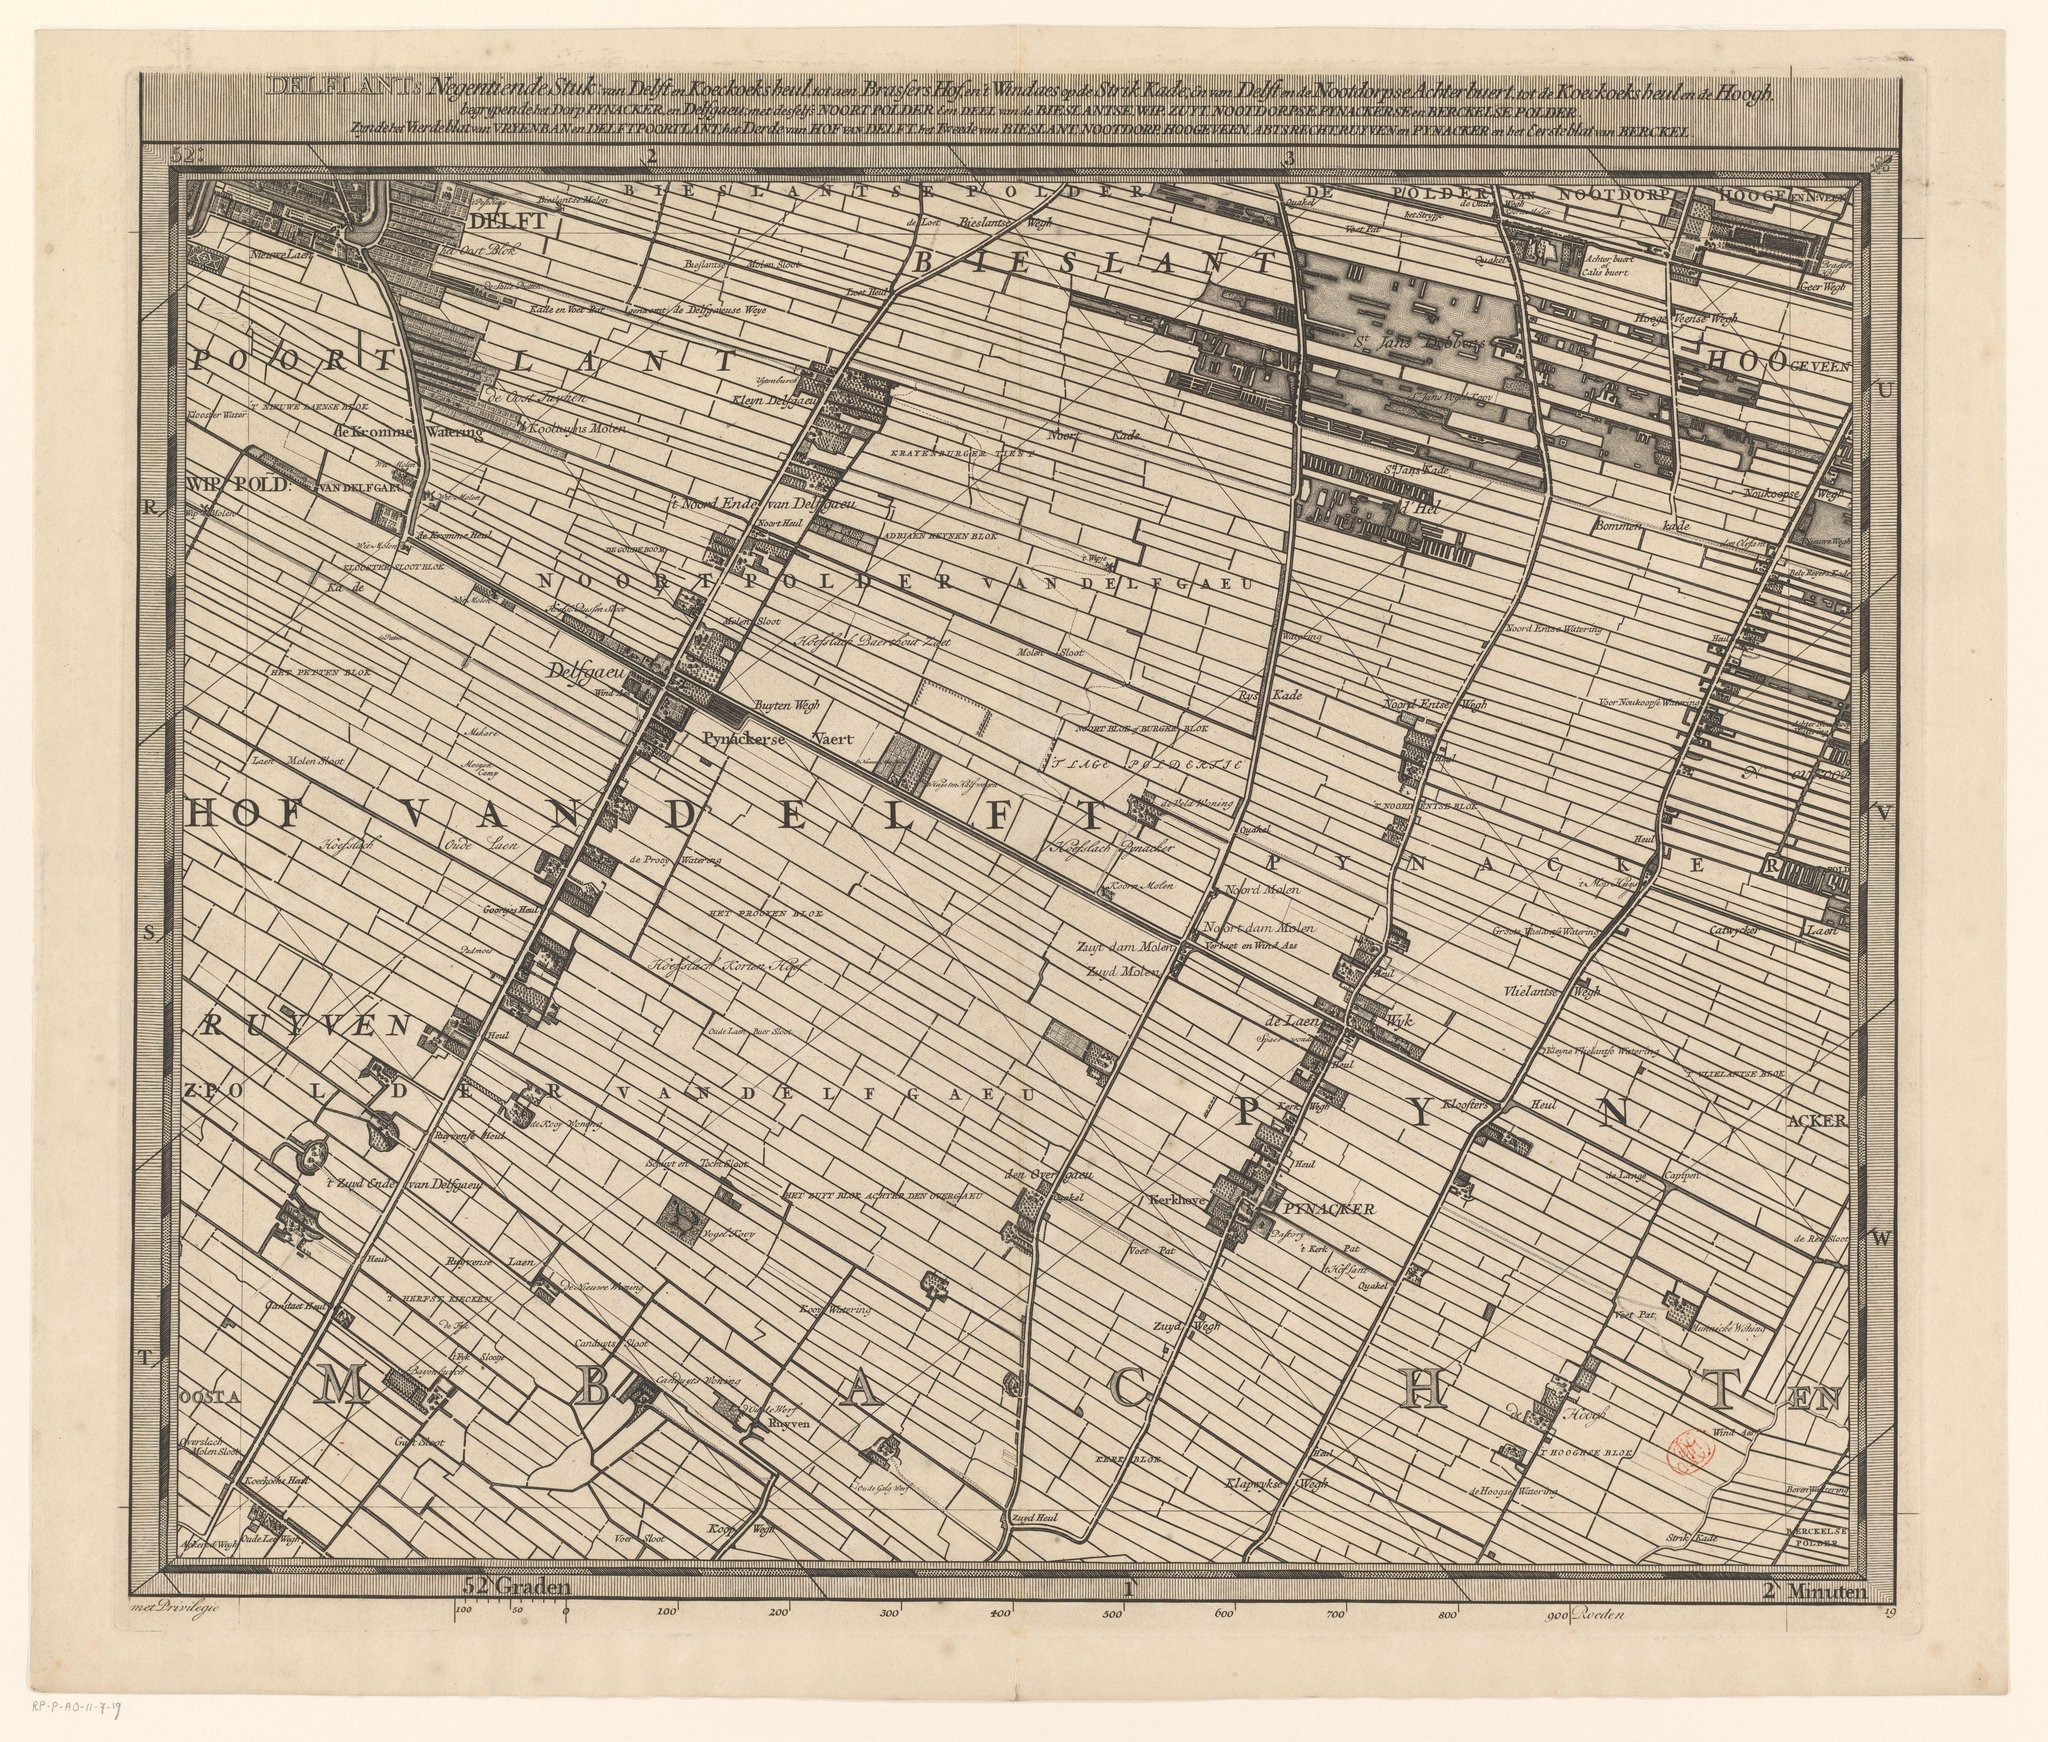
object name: map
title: 'T Hooge Heemraedschap van Delflant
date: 1712-1735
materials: paper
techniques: engraving, etching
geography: delft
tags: maps of cities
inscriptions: collector's mark: Lugt 2228, collector's mark: Lugt 195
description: Onderdeel van de grote wandkaart 'T Hooge Heemraedschap van Delflant. De kaart zelf bestaat uit vijfentwintig bladen, de titelstrook is gedrukt van twee platen. Meerdere prentmakers hebben aan deze kaart gewerkt. In volgorde van meest gewerkte dagen zijn dit: Luggert van Anse (1091 dagen), Thomas Doesburgh (952 dagen), Jacobus Deur (806 dagen), Johannes Deur (683 dagen) en Pieter Sluyter (151 dagen). Sluyter was verantwoordelijk voor de versieringen, de anderen voor de rest. Wie precies aan welk blad heeft gewerkt is niet duidelijk. Pieter Haringh had het ontwerp voor de wapenschilden geleverd en Arnold Houbraken het ontwerp voor de rest van de versieringen. Het drukken, uitgeven en verkopen van de kaart lag, zoals blijkt uit het privilege, in handen van het hoogheemraadschap. Voor zover bekend is de kaart in zijn geheel twee keer gedrukt, in 1712 en 1735. Het hoogheemraadschap beheerde de voorraad kaarten voor verkoop. In een aantal atlassen van Covens & Mortier (Nieuwe atlas inhoudende de vier gedeeltens der waereld (...). 5 delen. Amsterdam: Covens & Mortier, s.a. [1721-1759], dl. 3) zijn de zevenentwintig bladen van de kaart en de overzichtskaart opgenomen. Het is dus vermoedelijk niet zo dat de kaart voor deze atlassen opnieuw werd gedrukt. Waarschijnlijk werd een aantal exemplaren bij het hoogheemraadschap afgenomen.